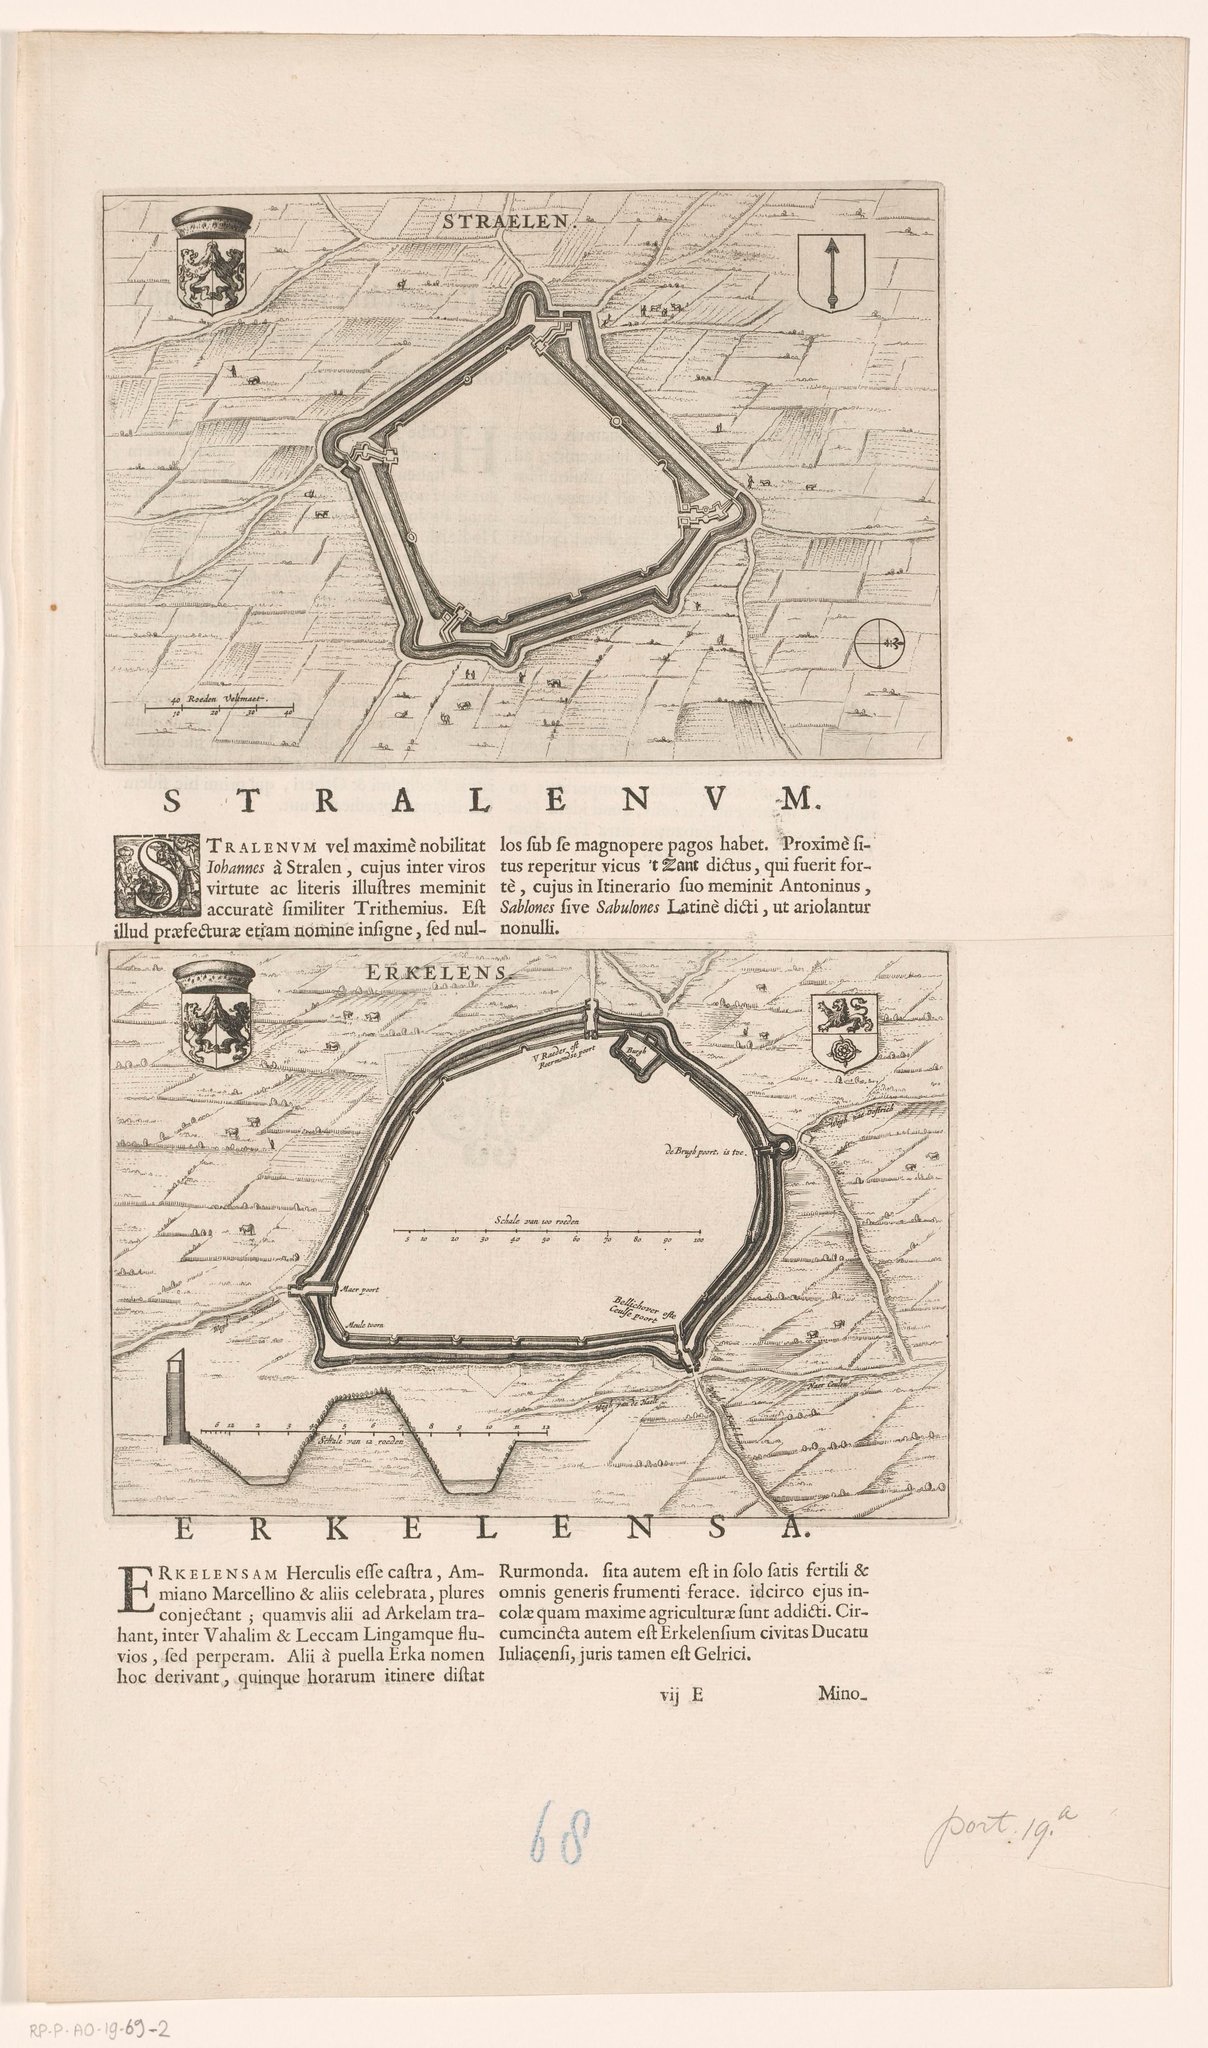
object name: area plan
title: Vestingplattegrond en beschrijving van Straelen en Erkelenz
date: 1652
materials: paper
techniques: engraving, etching, letterpress printing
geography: amsterdam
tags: coat of arms (as symbol of the state, etc.) (+ city; municipal), maps of cities, coat of arms (as symbol of the state, etc.) (+ province; provincial)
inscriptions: collector's mark: Lugt 2228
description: Boven een plattegrond van Straelen. Linksboven het wapen van het hertogdom Gelre, rechtsboven het wapen van Straelen. Linksonder een schaalstok: 40 Roeden Veltmaet. Hieronder een beschrijving van Straelen in het Latijn. Onder een vestingplattegrond van Erkelenz. Linksboven het wapen van het hertogdom Gelre, rechtsboven het wapen van Erkelenz. Linksonder een doorsnede van de wal voor de vesting, met schaalstok: Schale van 12 roeden. Hieronder een beschrijving van Erkelenz in het Latijn. Met Latijnse tekst op verso.